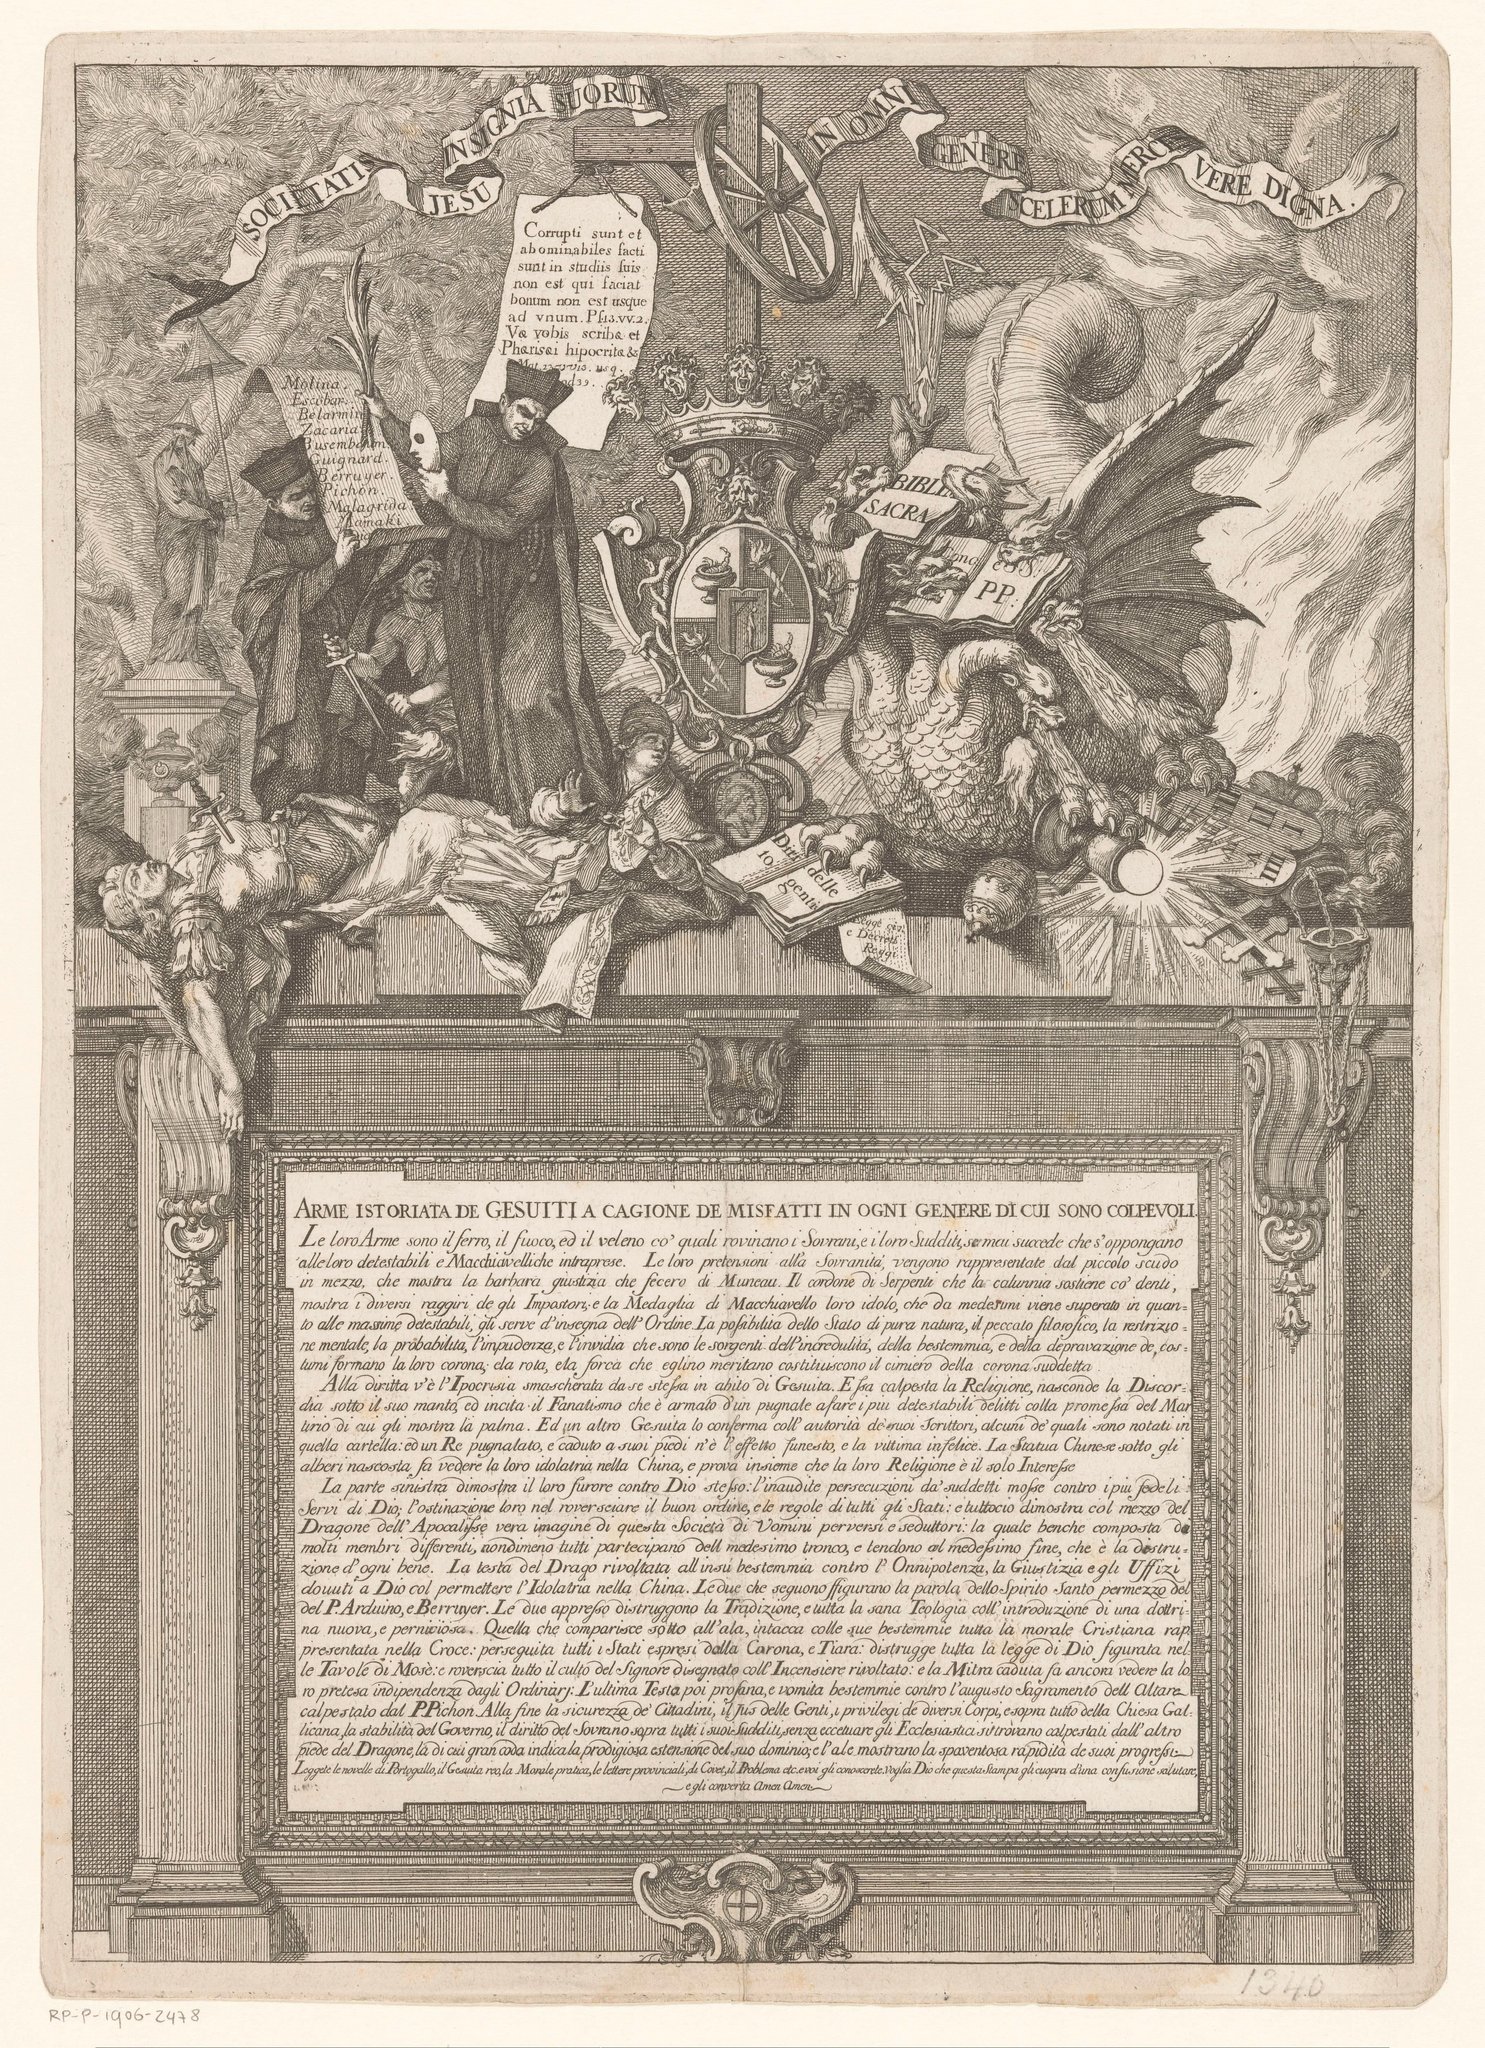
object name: print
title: Allegorische voorstelling met zevenkoppige draak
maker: Anonymous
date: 1700-1799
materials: paper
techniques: etching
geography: italy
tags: instruments of torture, execution or punishment: gallows, dragon with seven heads ~ the seven deadly sins symbolized, cardinal, pope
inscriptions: collector's mark: Lugt 2228, inscription: ‘Allegorische voorstelling opde societeit der Jezuiten met Ital. bijschrift 40 c’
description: Boven een allegorische voorstelling met onder meer een zevenkoppige draak, een paus en een wiel hangend aan een galg. Onder een tekst in het Italiaans.